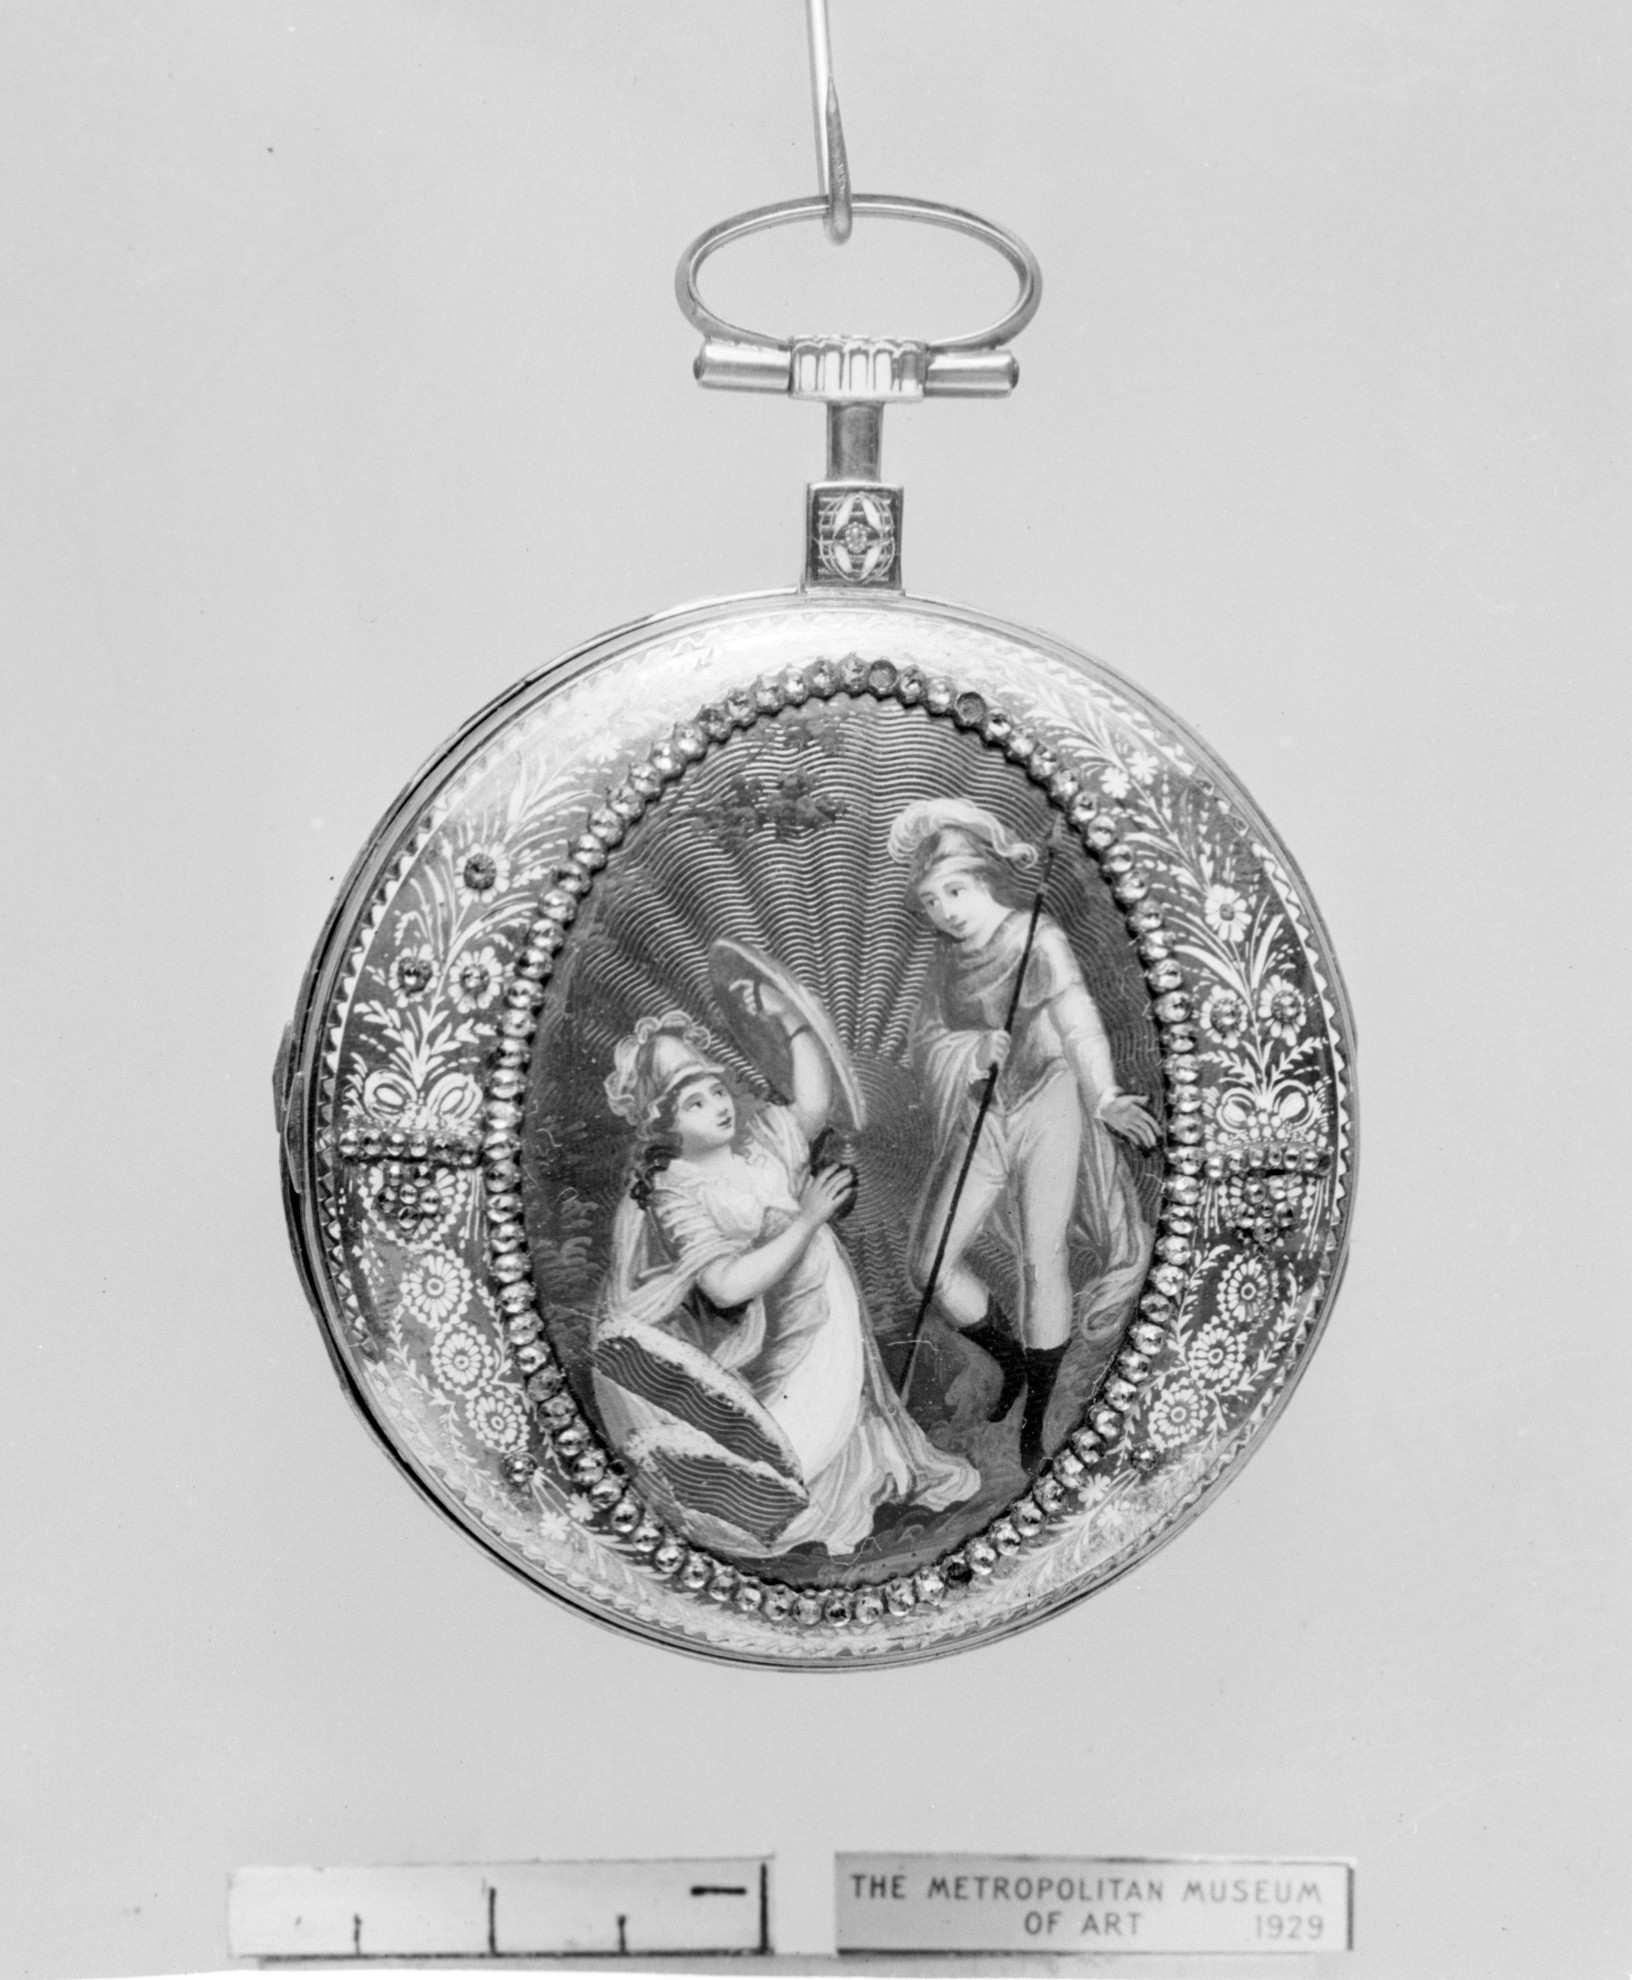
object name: watch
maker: pierre gregson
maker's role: maker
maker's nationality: british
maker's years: 1778-1795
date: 1767-1800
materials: diamond, enamel, gold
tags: shields,men,women,leaves